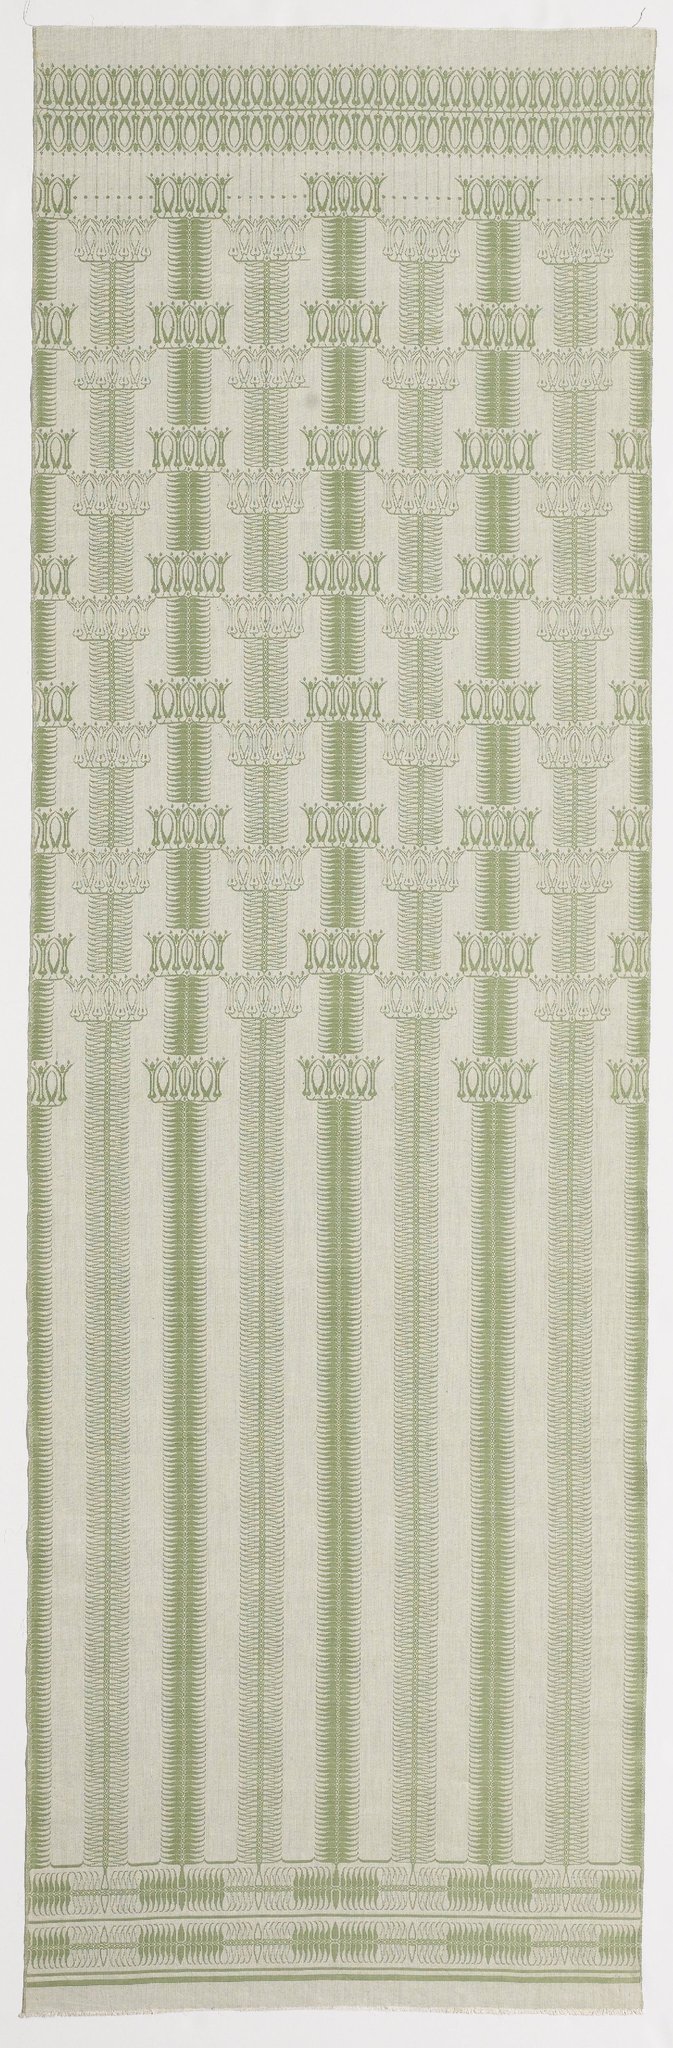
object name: upholstered wall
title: Wandbespanning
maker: chris lebeau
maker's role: draughtsman, print maker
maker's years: 1878-1945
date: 1911-1915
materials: linen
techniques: damask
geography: eindhoven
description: Olijfgroene damasten wandbespanning met een dessin van nagelbloemen.